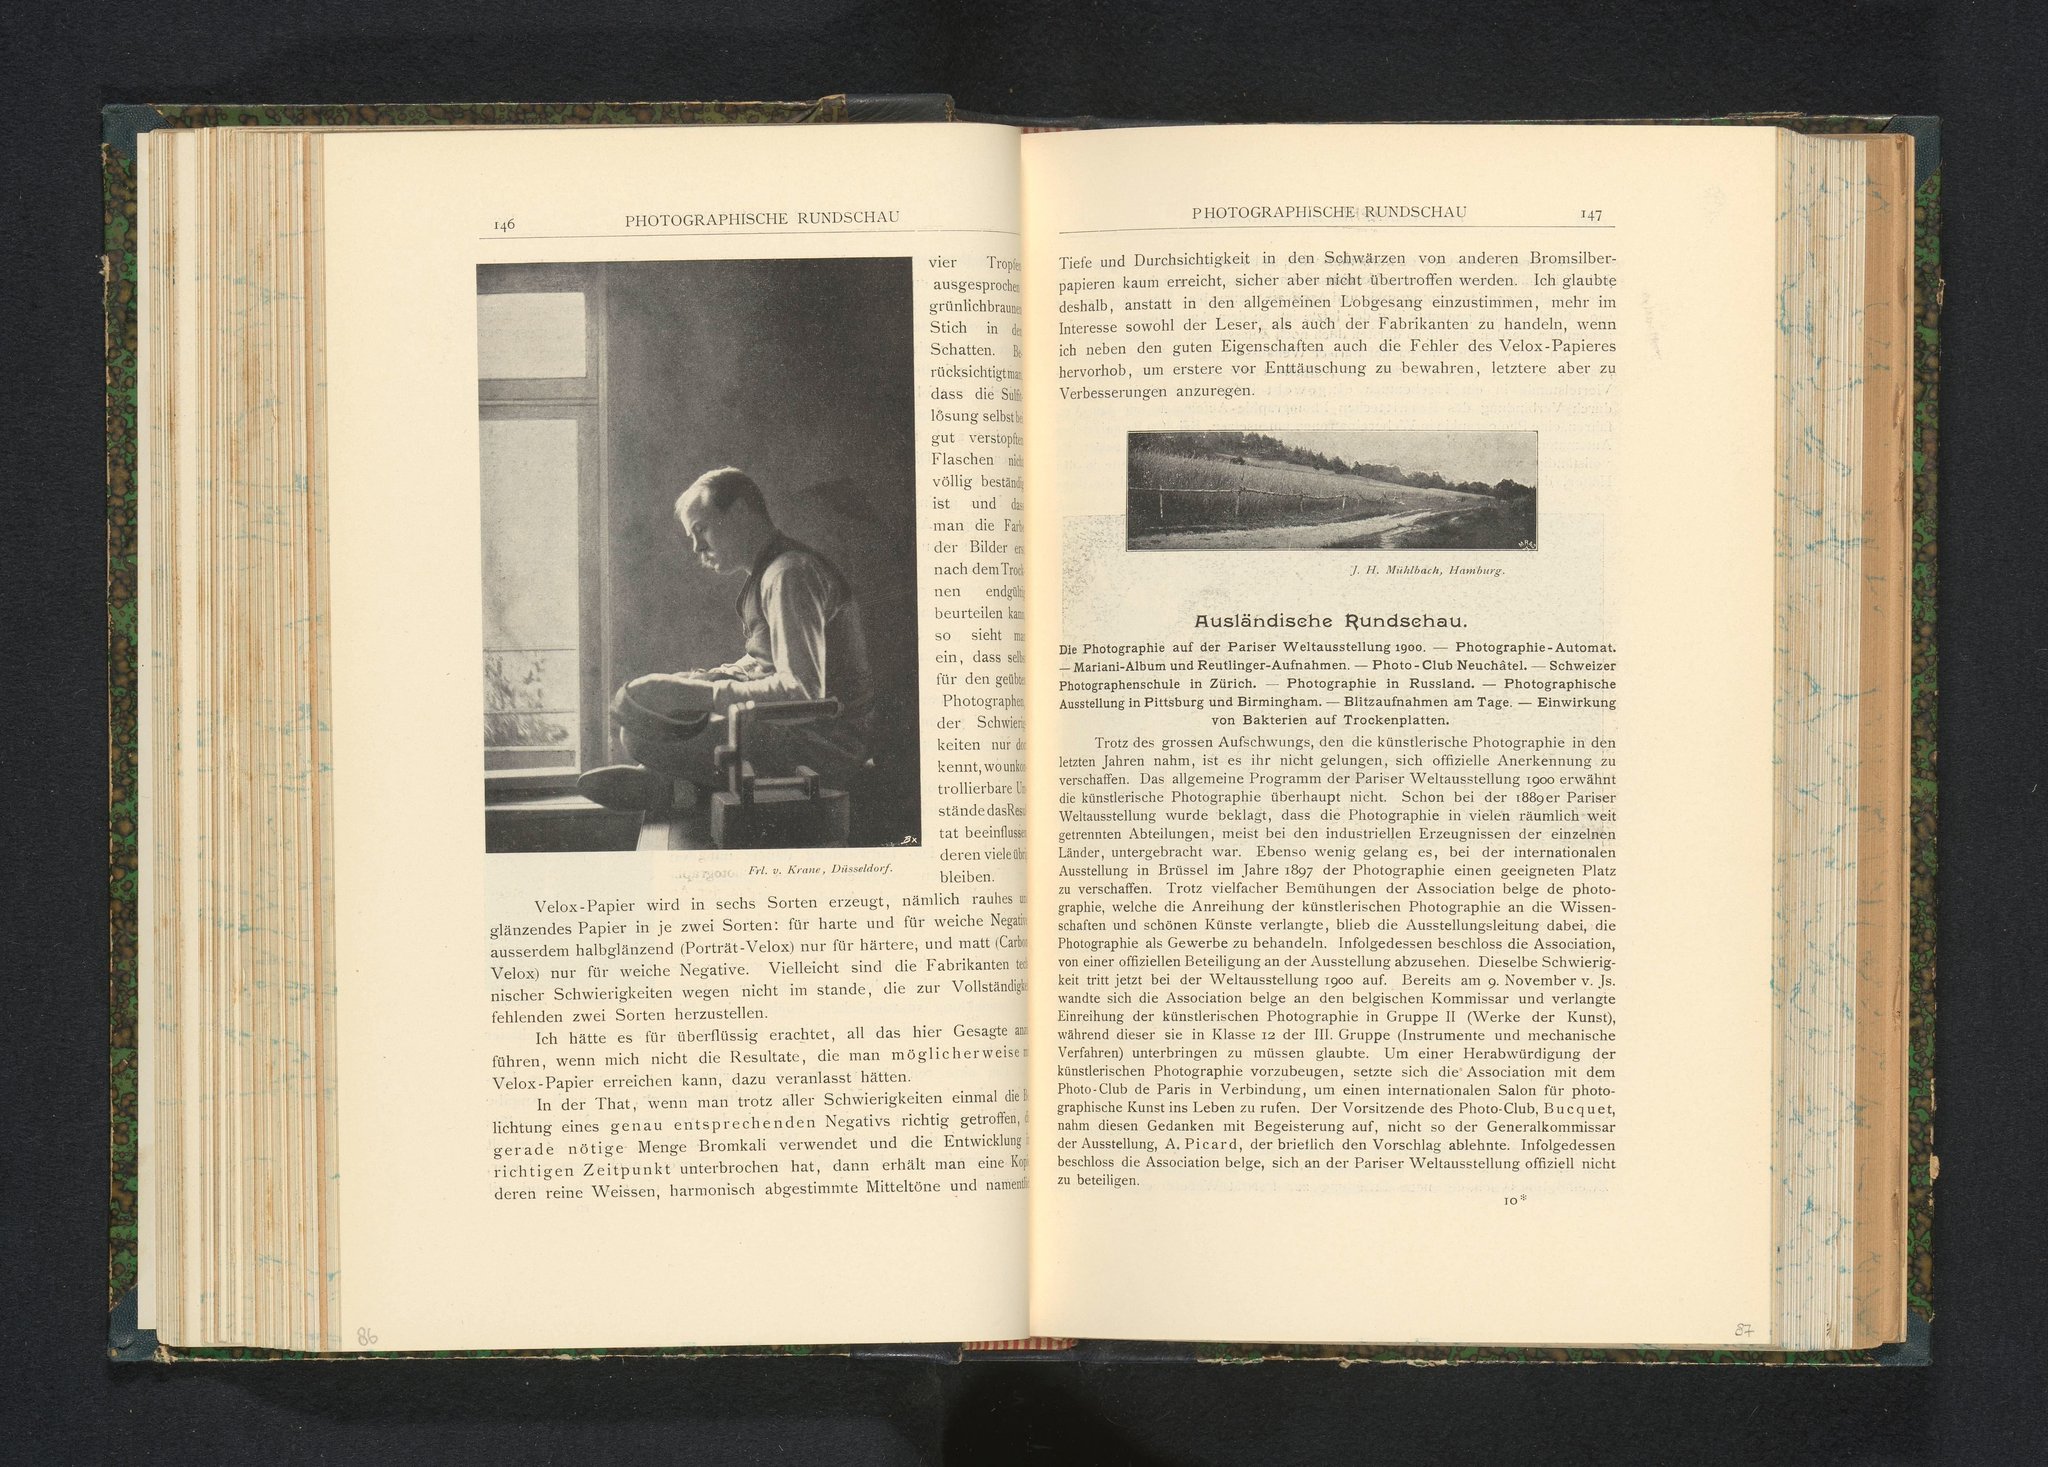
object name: page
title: Ambachtsman bij een raam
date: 1894-1899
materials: paper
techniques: autotype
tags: handicrafts, craftsman at work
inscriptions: monogram: ‘BX’